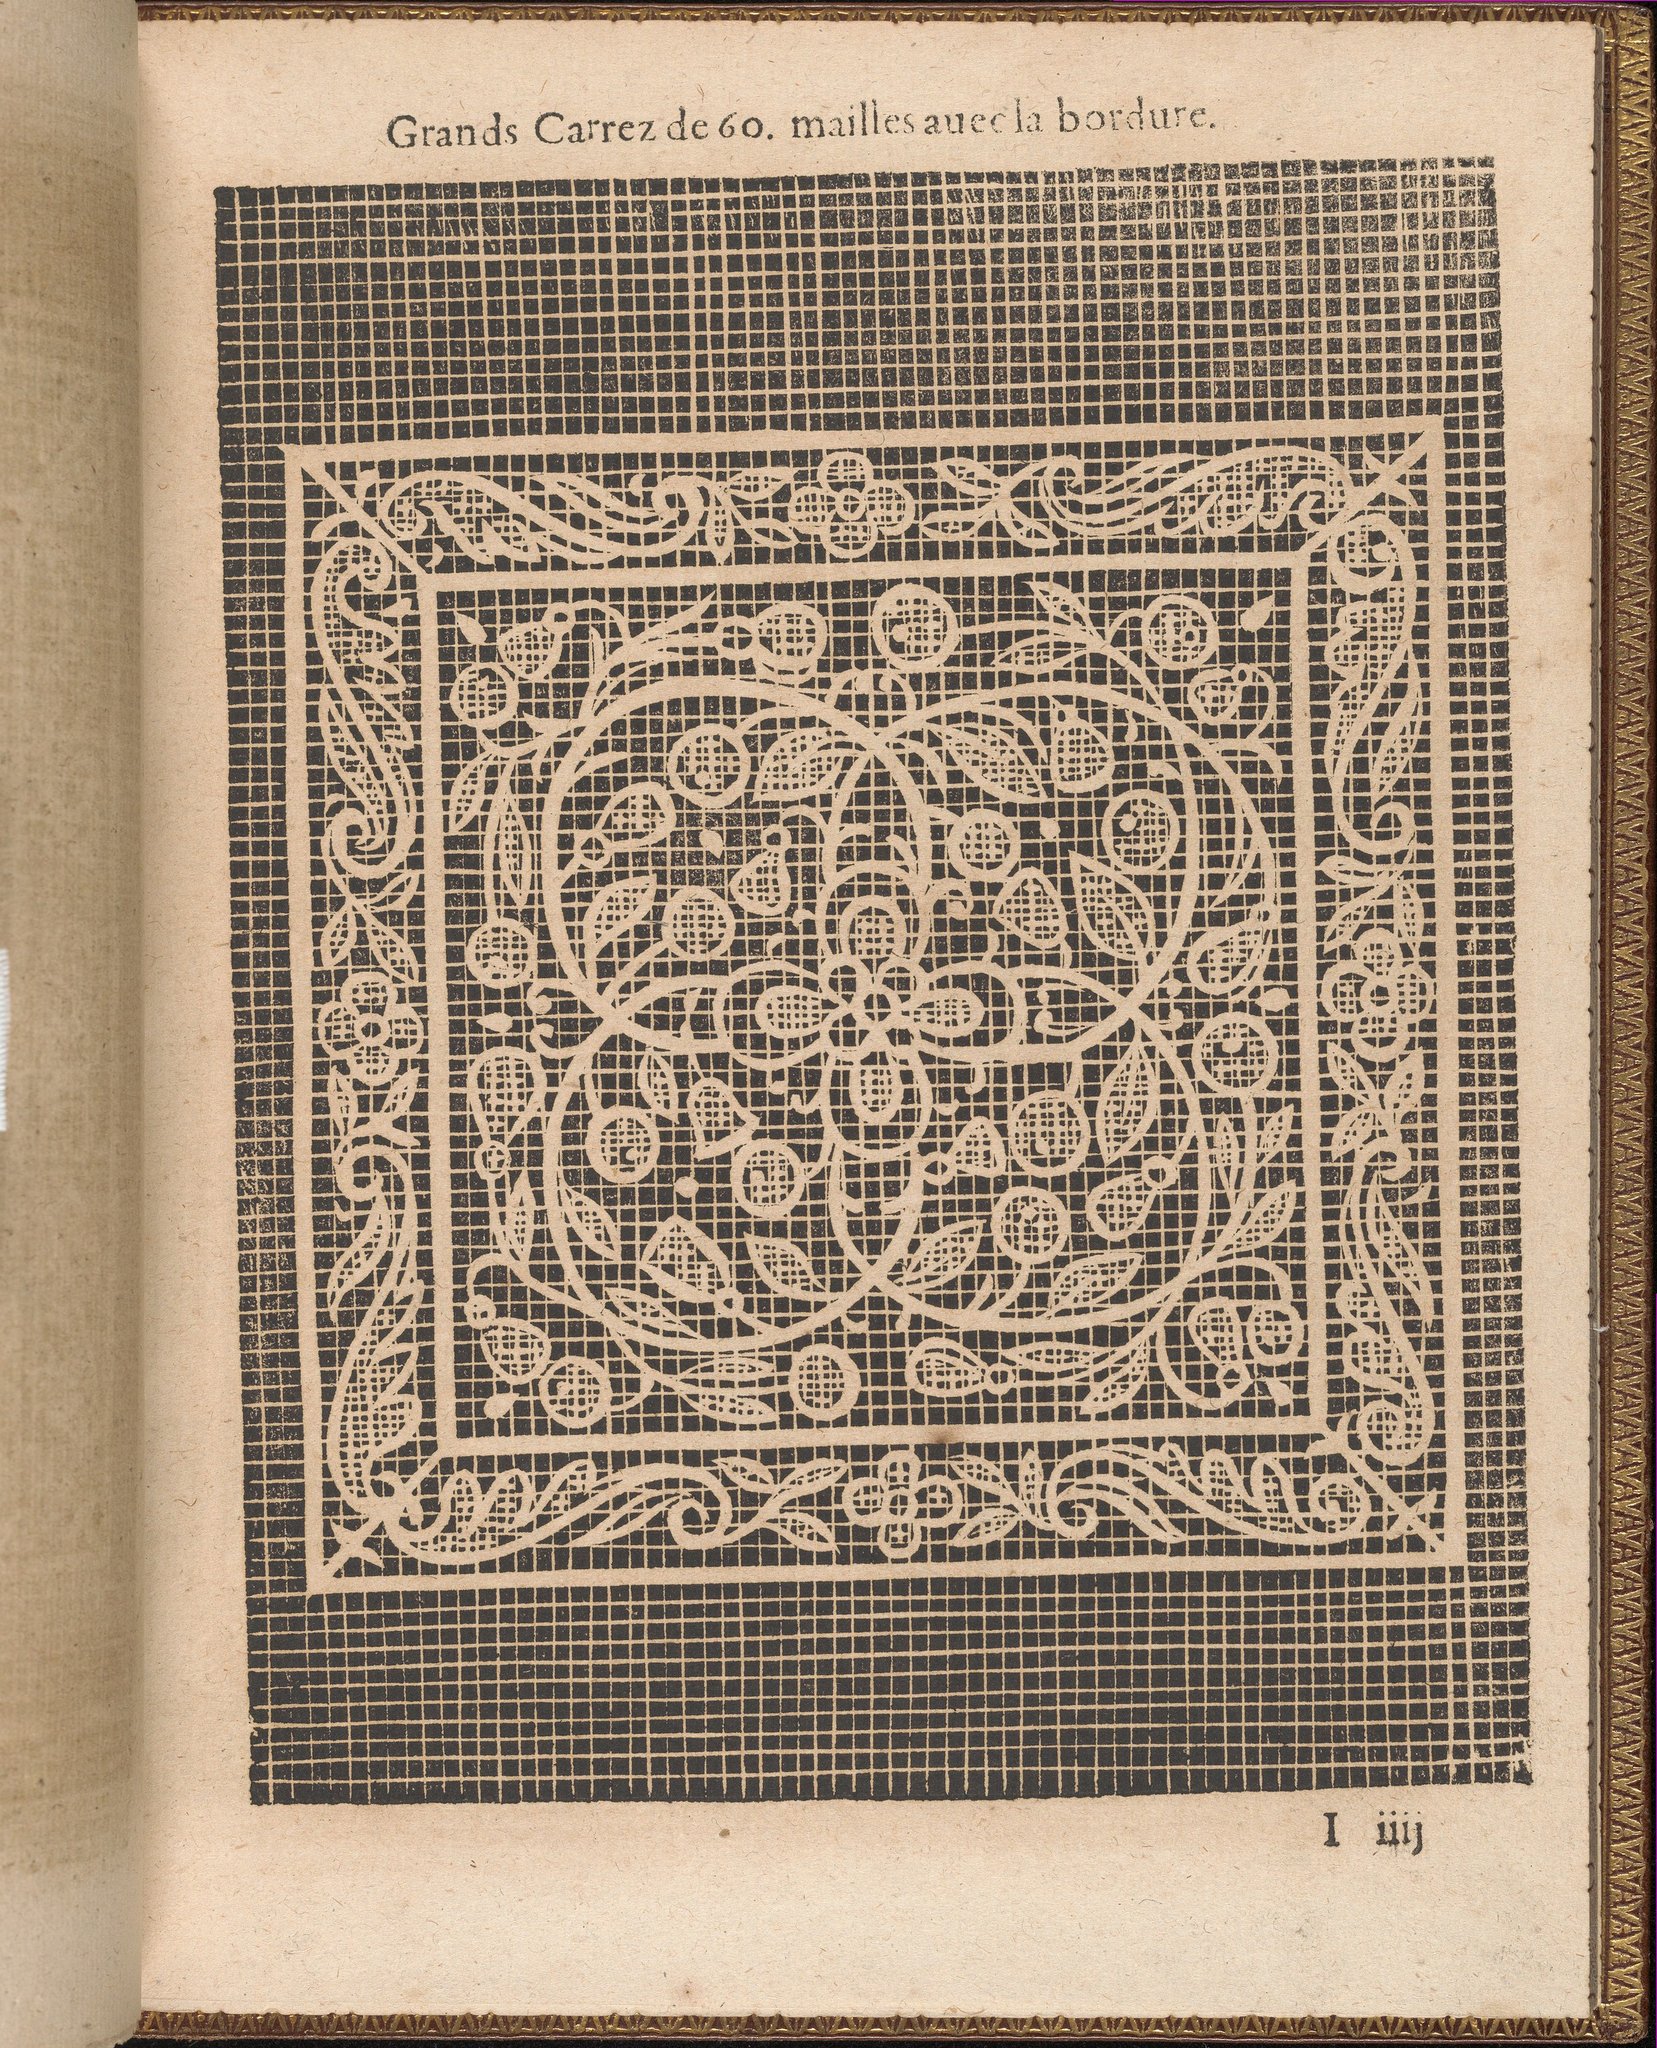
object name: book print ornament architecture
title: La Pratique de l'Aiguille, page 35 (recto)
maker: matthias mignerak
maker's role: author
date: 1605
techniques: woodcut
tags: flowers